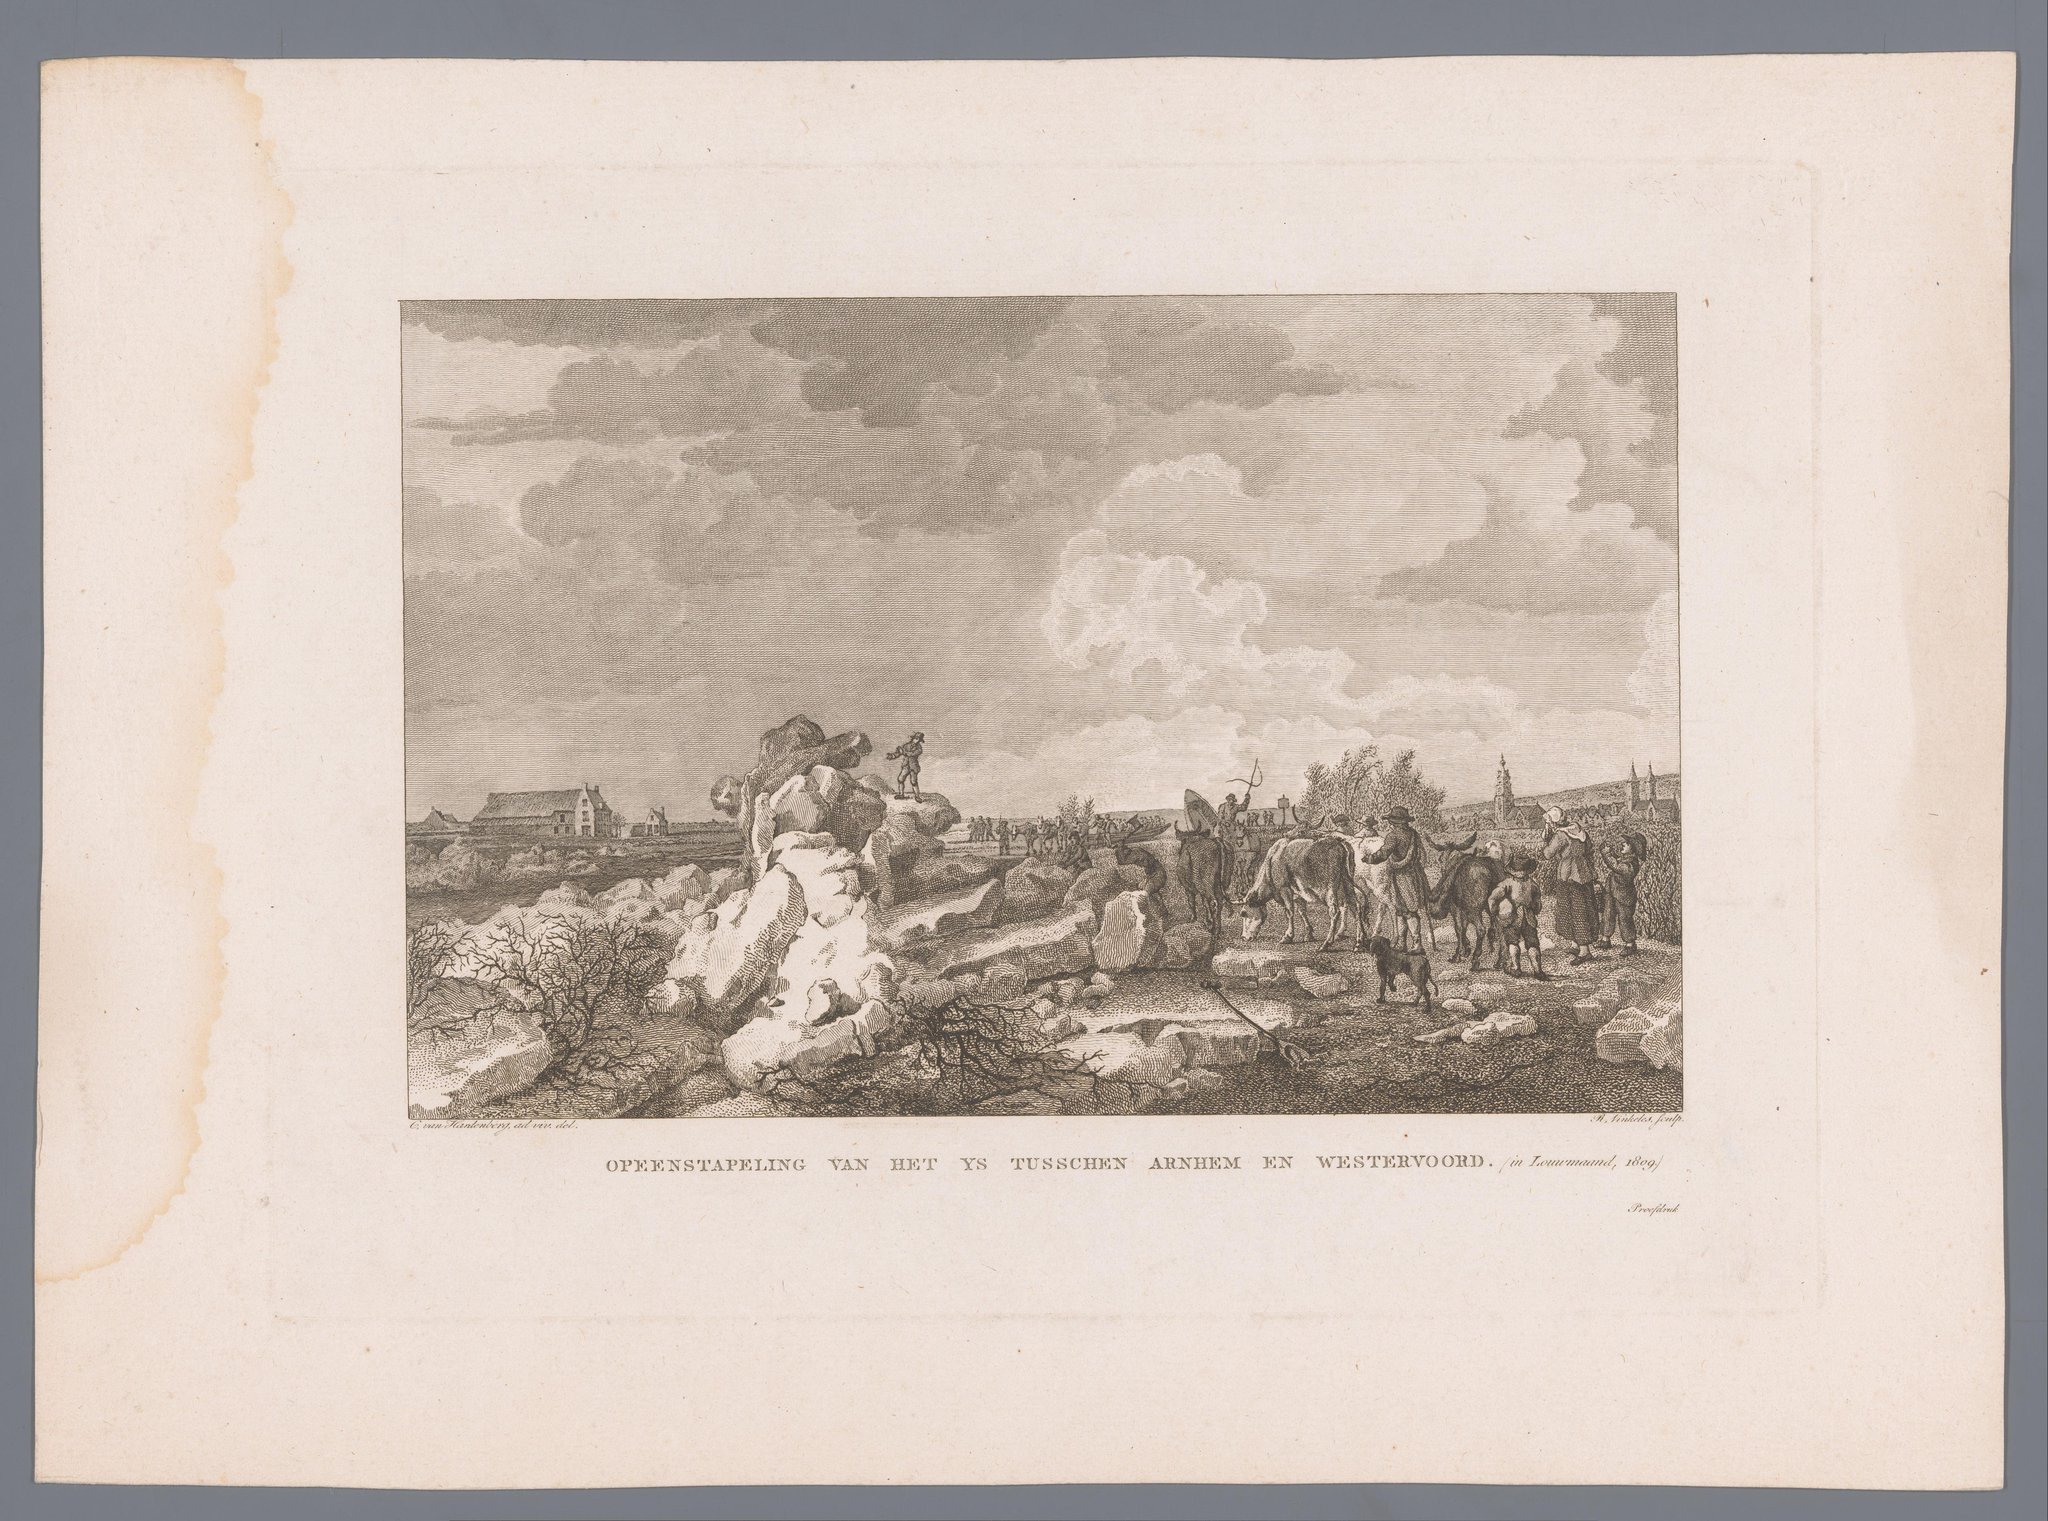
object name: print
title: Kruiend ijs tussen Arnhem en Westervoort, 1809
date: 1809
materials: paper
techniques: etching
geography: netherlands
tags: dike-break, drift ice, prospect of city, town panorama, silhouette of city (+ city(-scape) with figures, staffage), arnhem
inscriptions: collector's mark: Lugt 2233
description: Prent uit: Ewijk, Hendrik. Geschiedkundig verslag der dijkbreuken en overstroomingen, langs de rivieren in het Koningrijk Holland, voorgevallen in louwmaand MDCCCIX. Amsterdam: Johannes Allart en Jacobus Ruys, 1809.